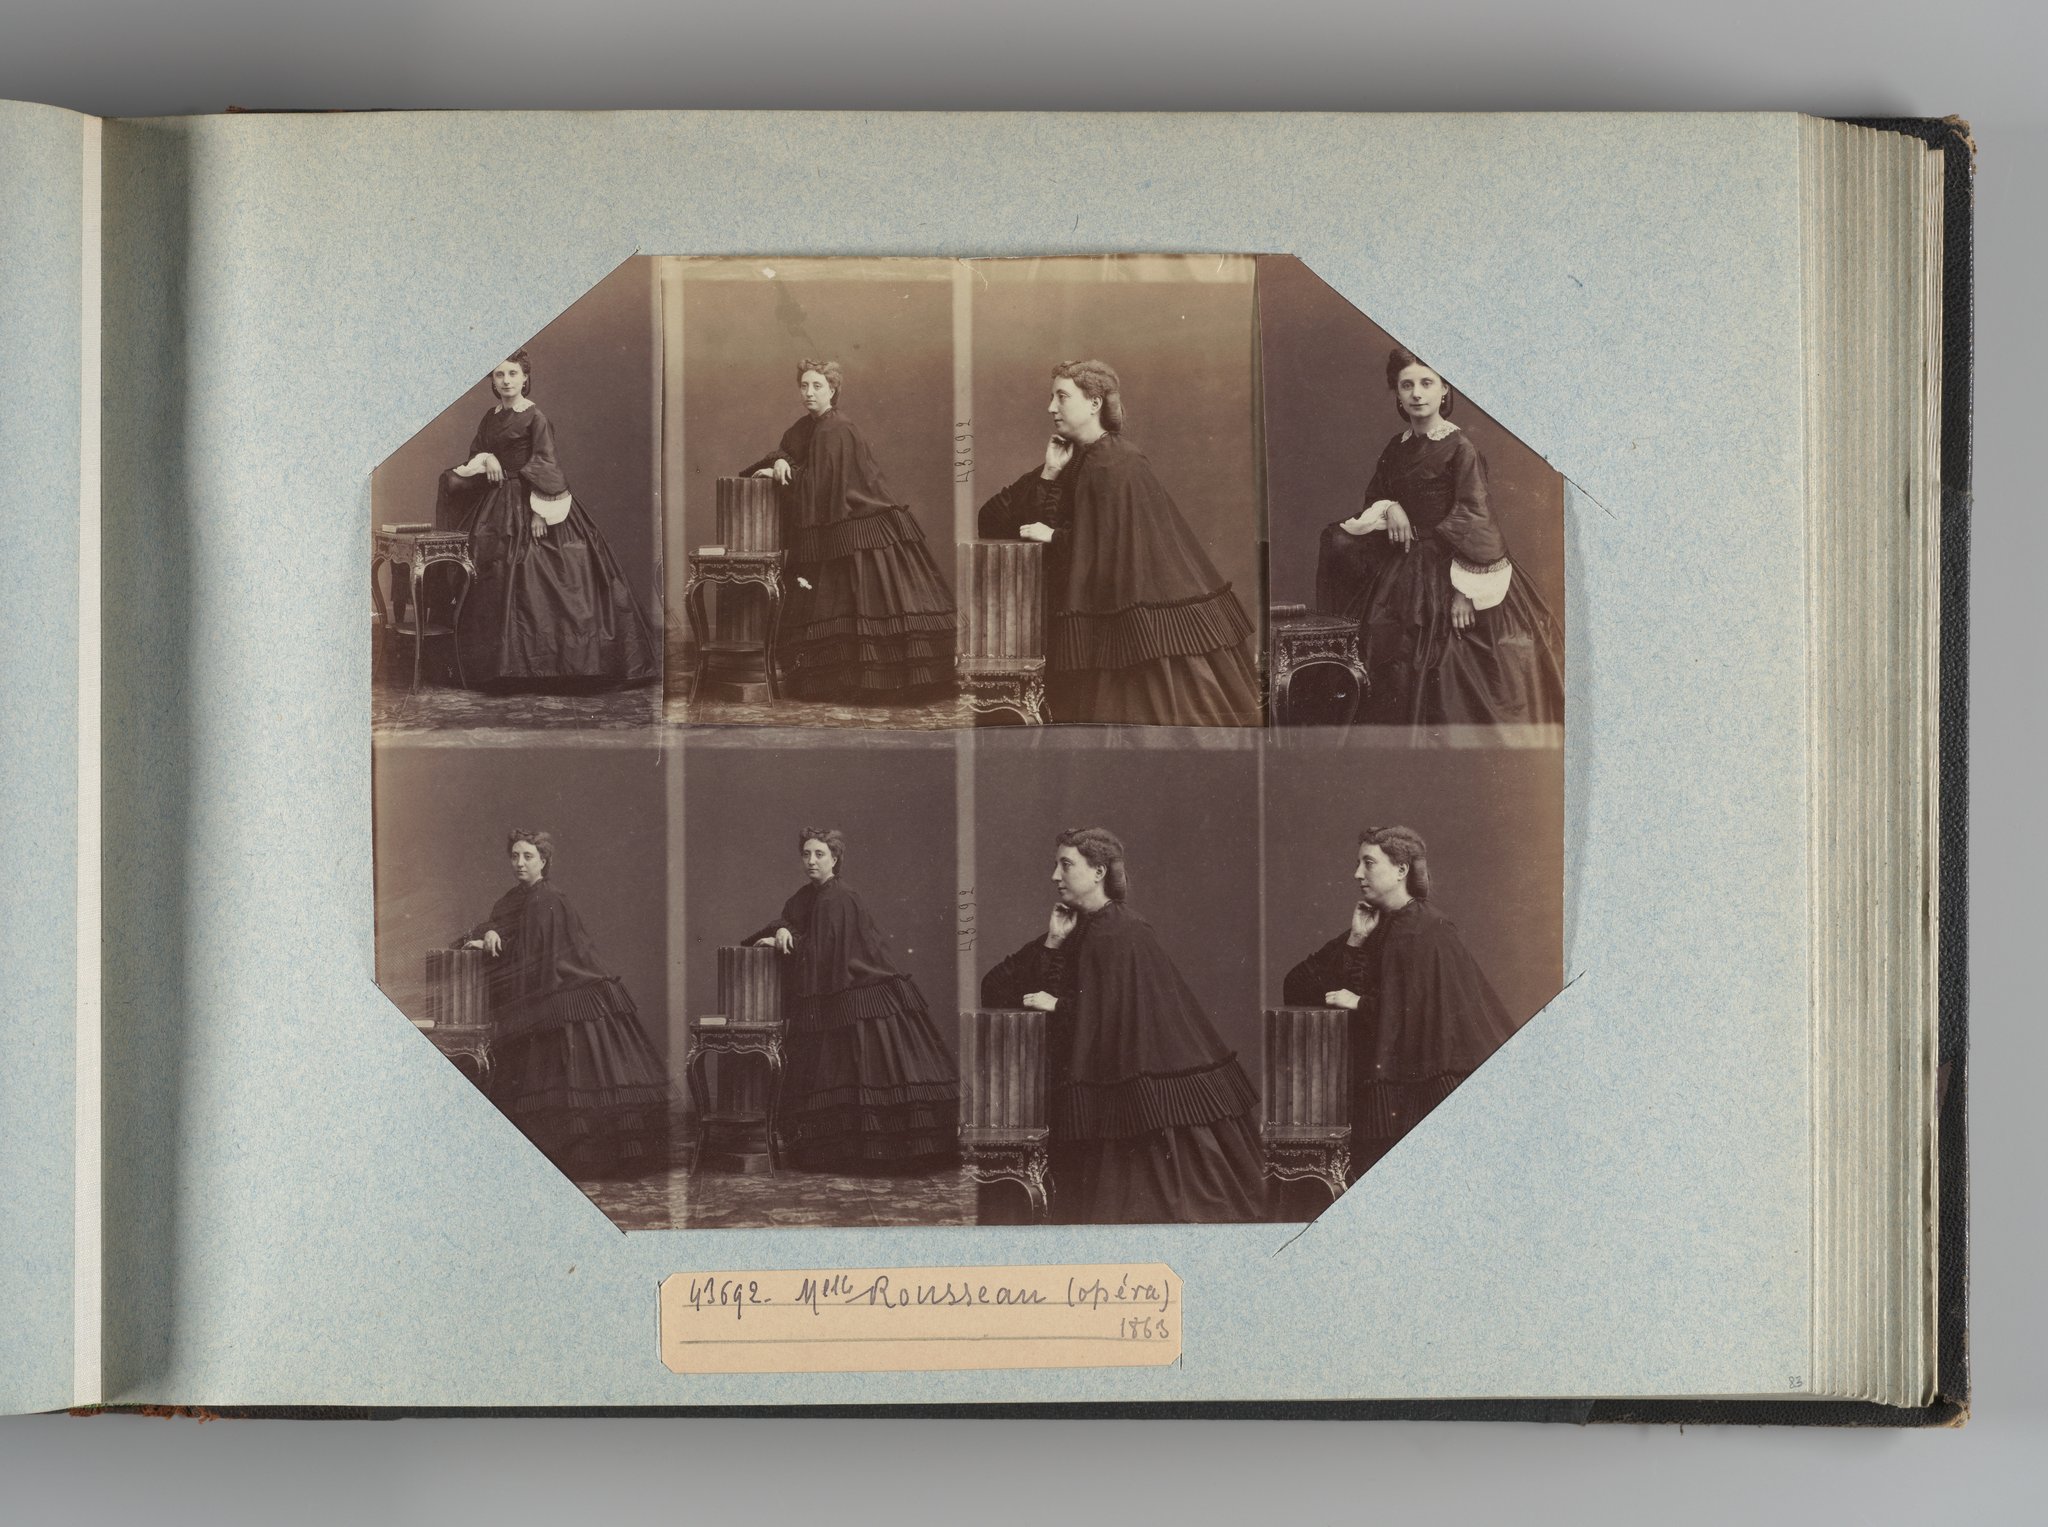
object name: photograph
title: Mlle Rousseau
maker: andré-adolphe-eugène disdéri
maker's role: artist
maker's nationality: french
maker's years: 1819-1889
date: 1863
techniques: albumen silver print, glass negative